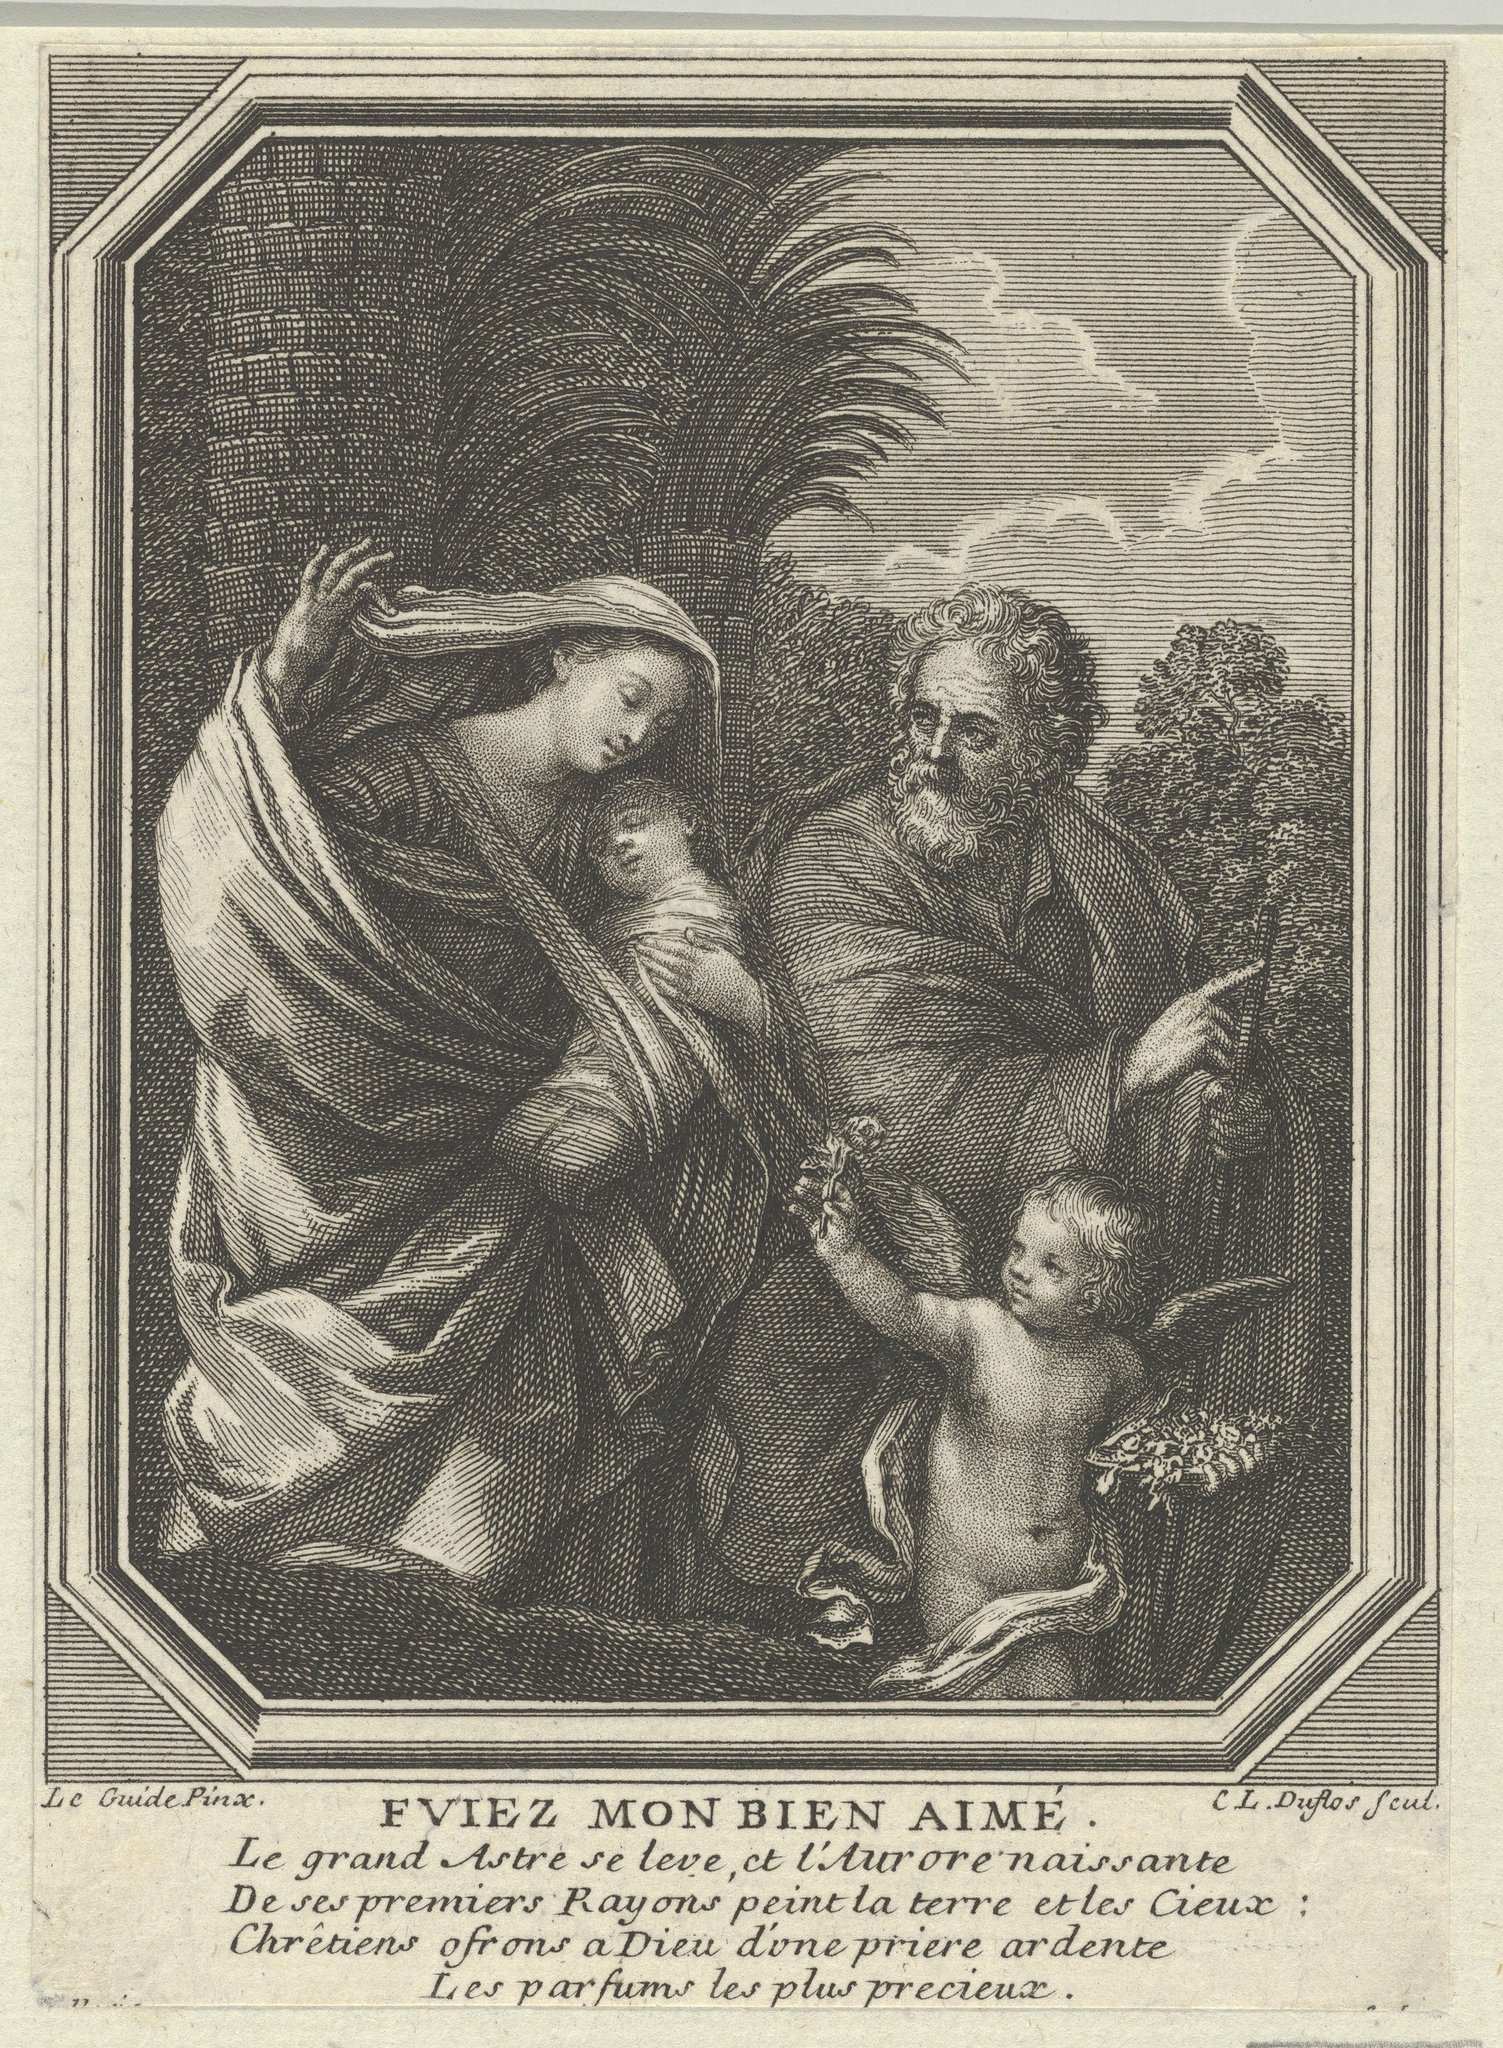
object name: print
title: The Flight into Egypt; the holy family walking with the young John the Baptist, trees behind them, in an octagonal frame, after Reni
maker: claude augustin duflos le jeune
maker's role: artist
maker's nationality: french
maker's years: 1700-1786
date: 1720-1786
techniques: engraving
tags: christ,holy family,saint john the baptist,saint joseph,virgin mary